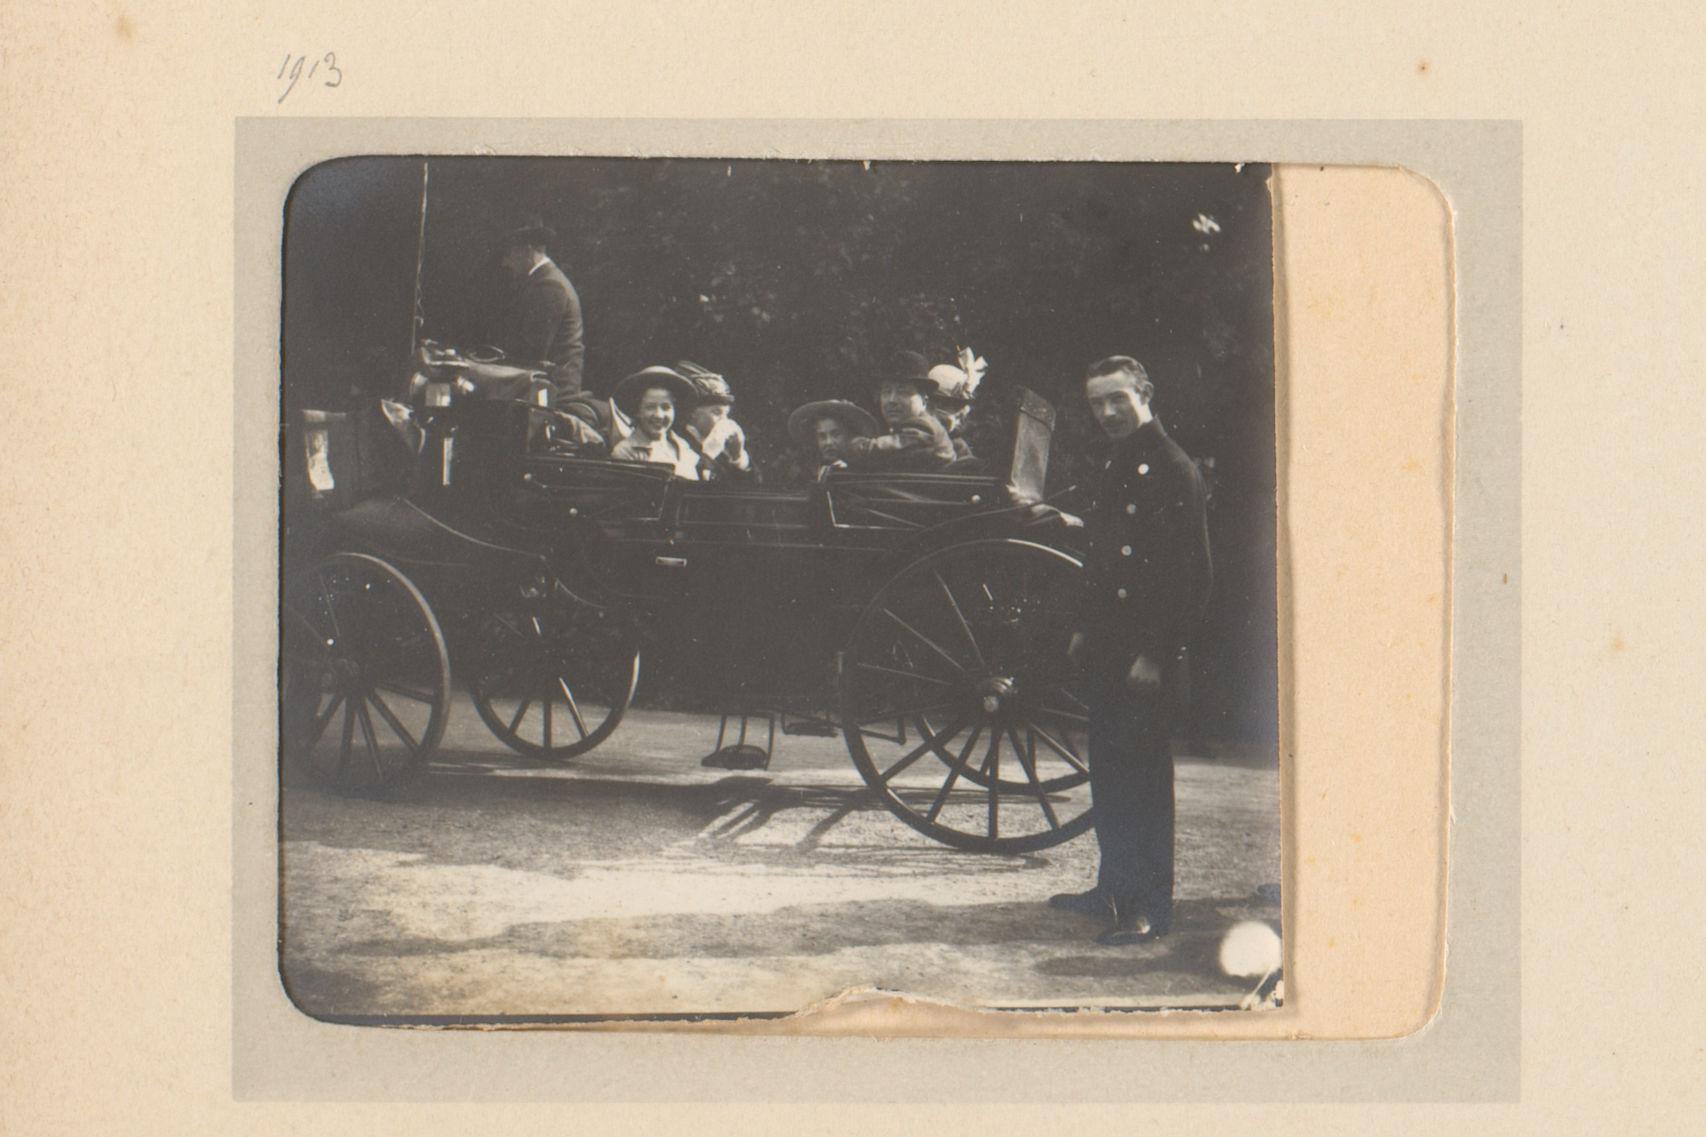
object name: album leaf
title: Gezelschap in een rijtuig, man staat ernaast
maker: liesbeth overhoff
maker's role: fotograaf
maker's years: 1895-1969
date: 1913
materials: paper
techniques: gelatin silver print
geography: oberhof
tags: four-wheeled, animal-drawn vehicle, e.g.: cab, carriage, coach, historical persons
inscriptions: inscription: ‘1913.’